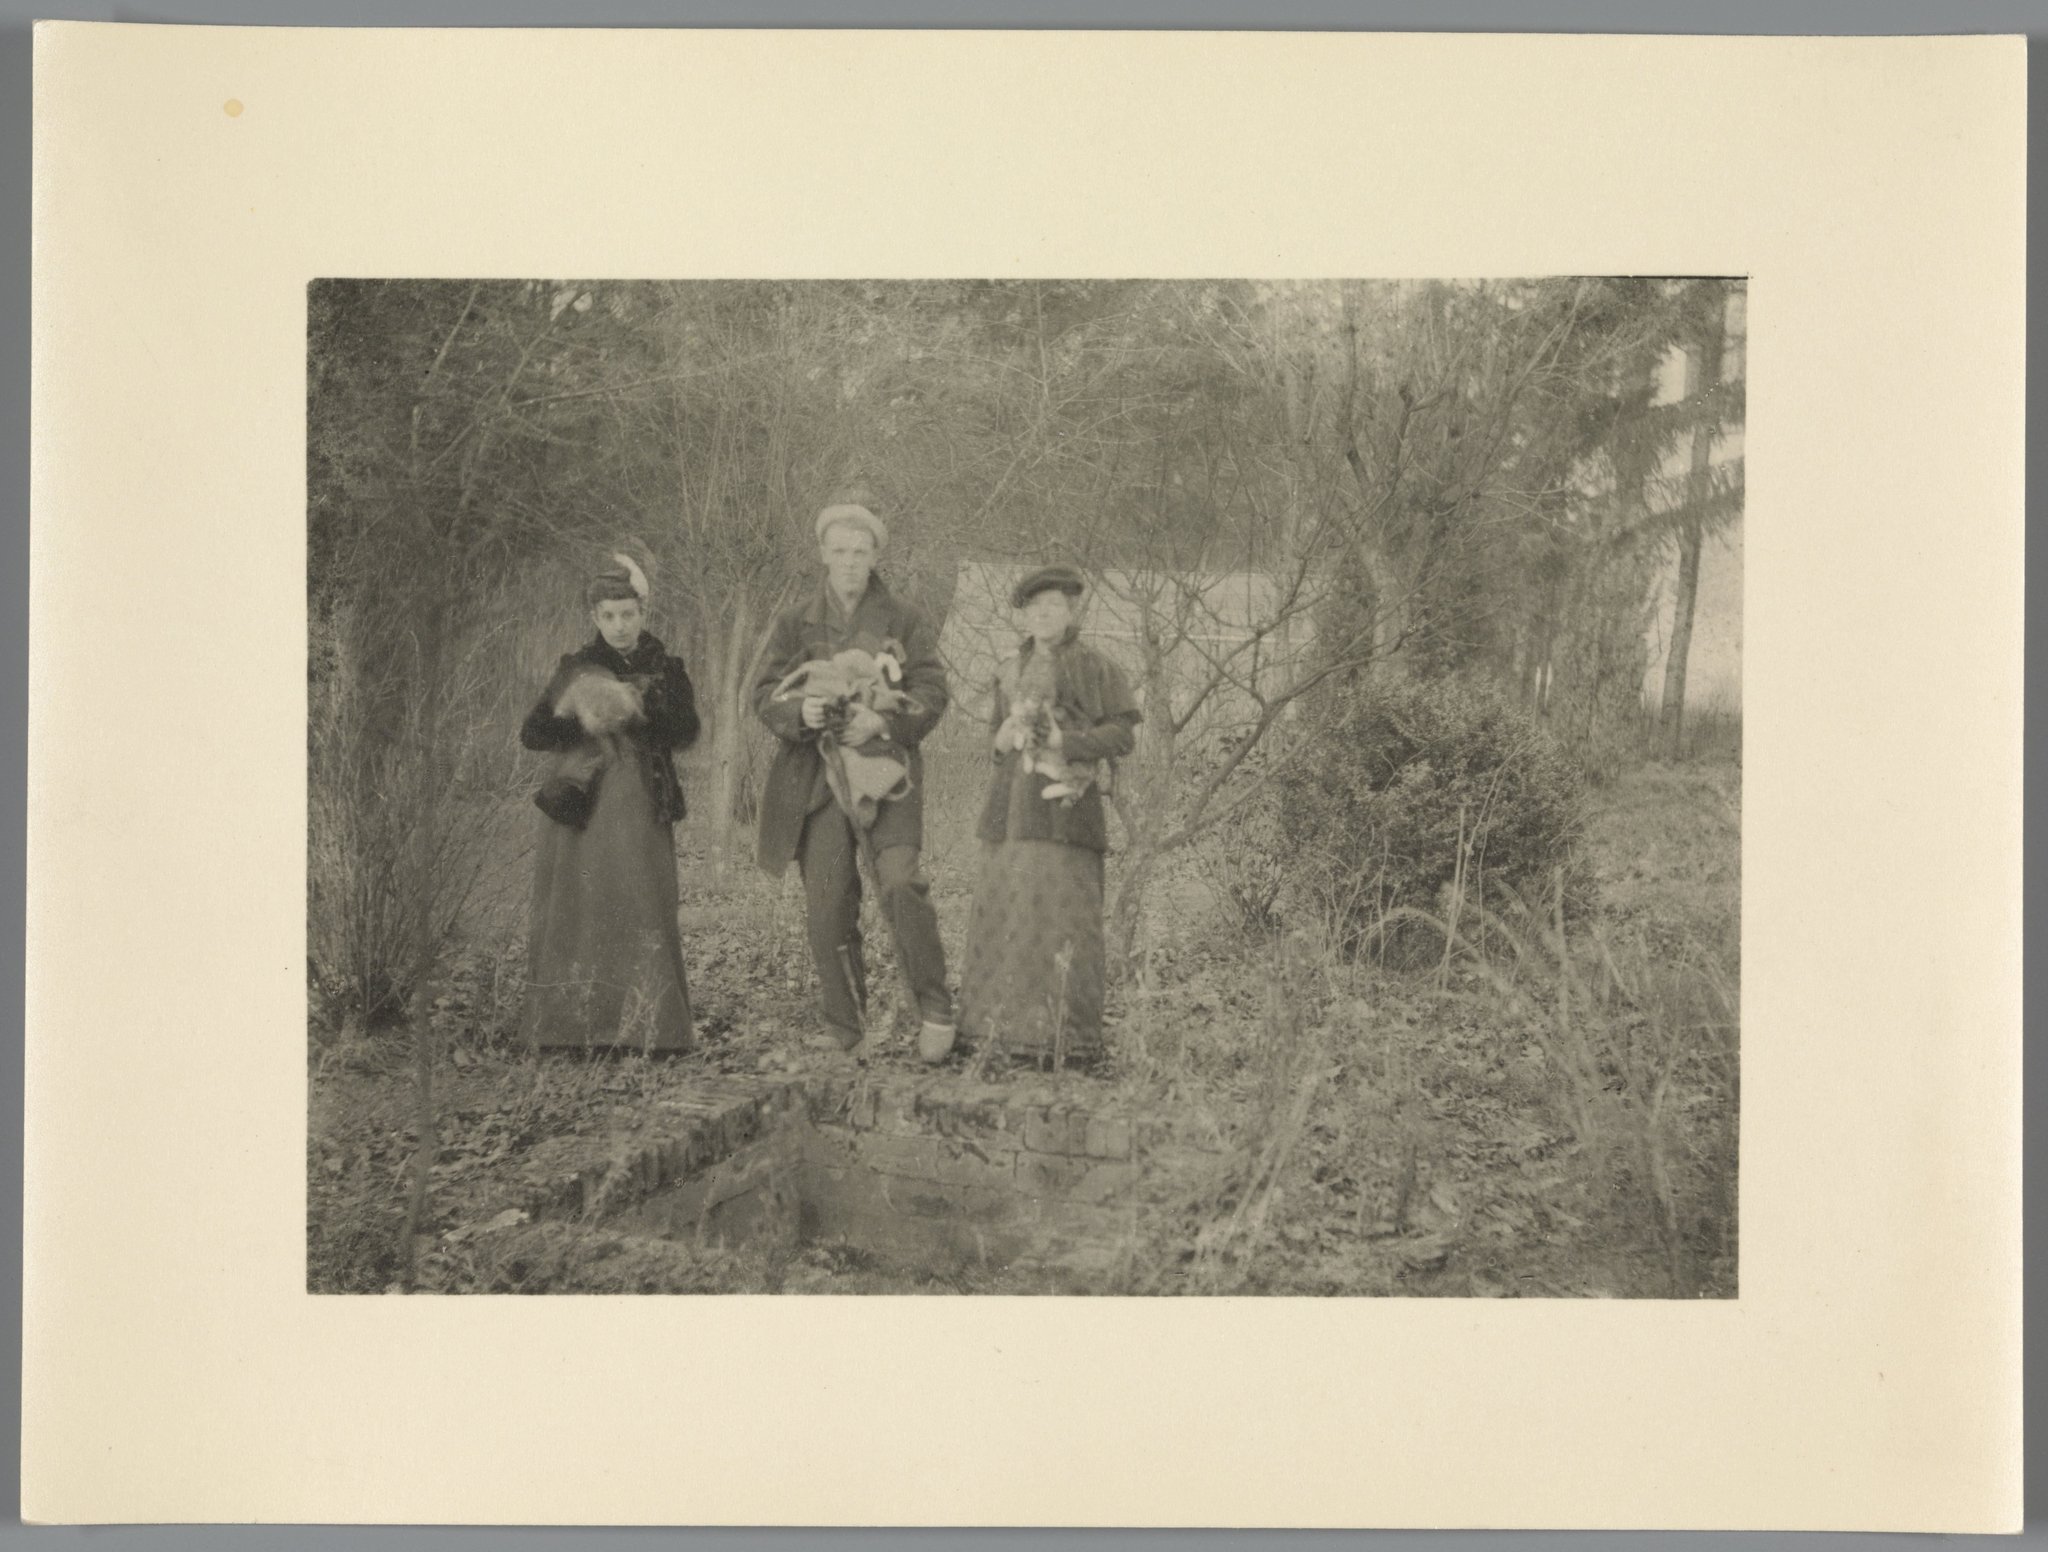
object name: photograph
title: Reproductie naar een foto van Willem Witsen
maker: Anonymous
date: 1860-1915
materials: paper, photographic support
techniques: gelatin silver print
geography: netherlands